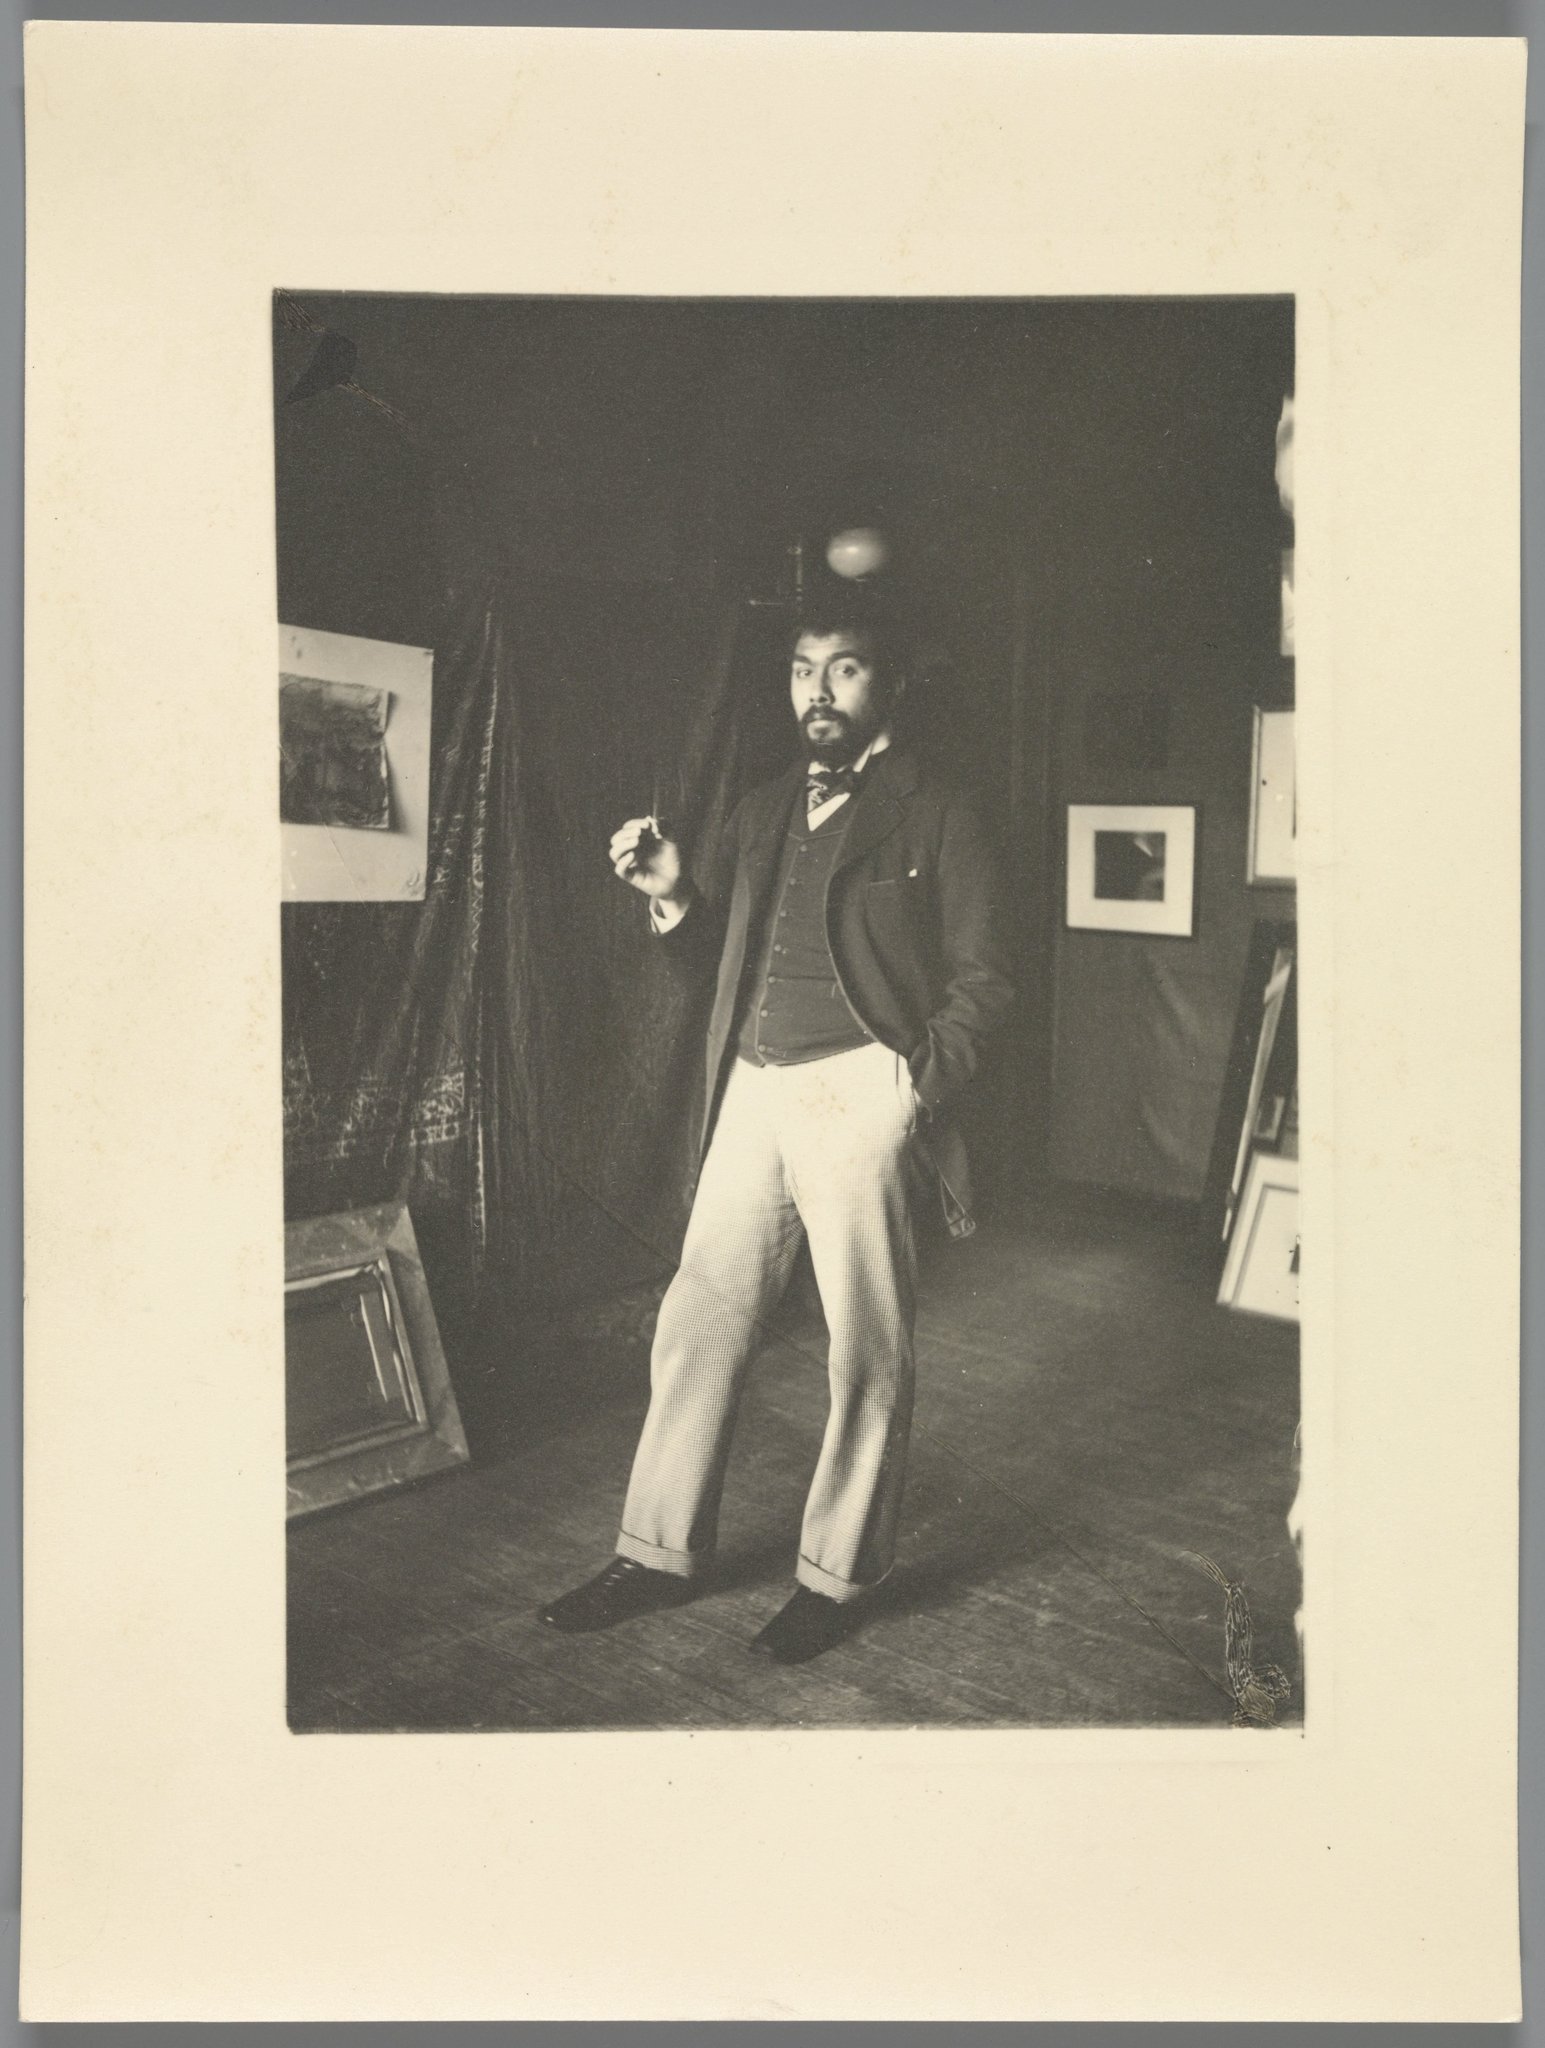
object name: photograph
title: Reproductie naar een foto van Willem Witsen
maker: Anonymous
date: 1860-1915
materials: paper, photographic support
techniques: gelatin silver print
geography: netherlands